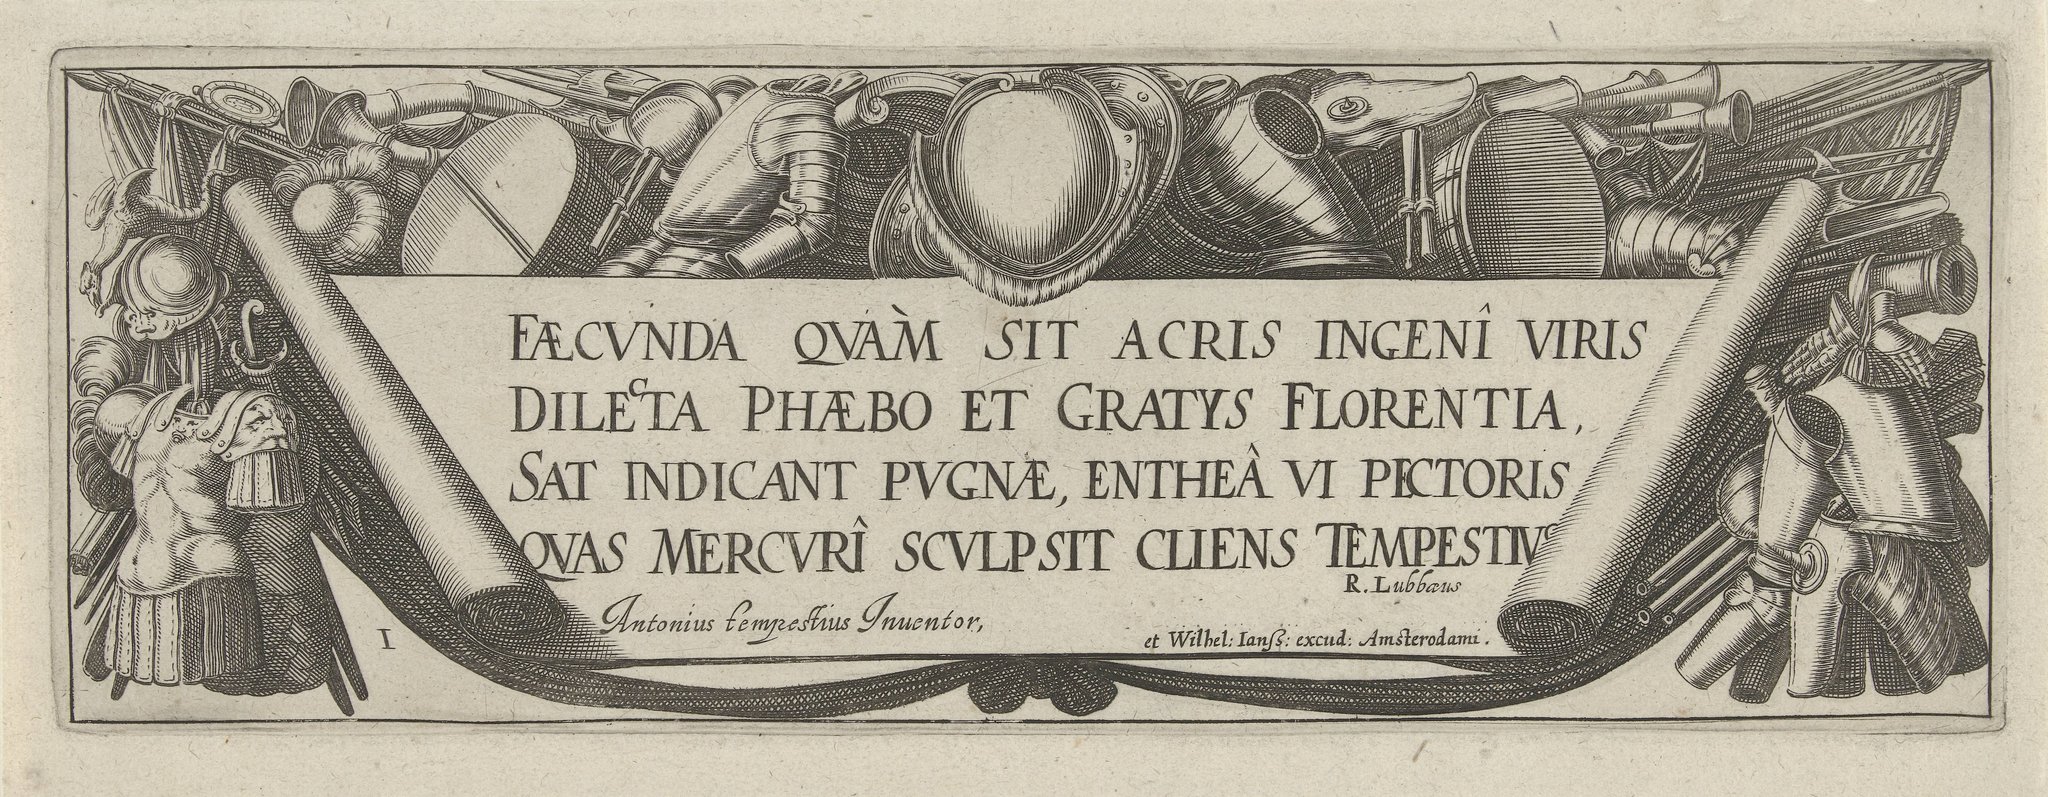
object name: print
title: Banderol omringd door militaria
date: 1608-1639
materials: paper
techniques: engraving, etching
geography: italy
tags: (military) equipment and supply (+ weapons), ribbon, scroll, banderole ~ ornament - aa - stylized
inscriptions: collector's mark: Lugt 2228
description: Een banderol met een tekst in het Latijn wordt omgeven door verschillende militaria.